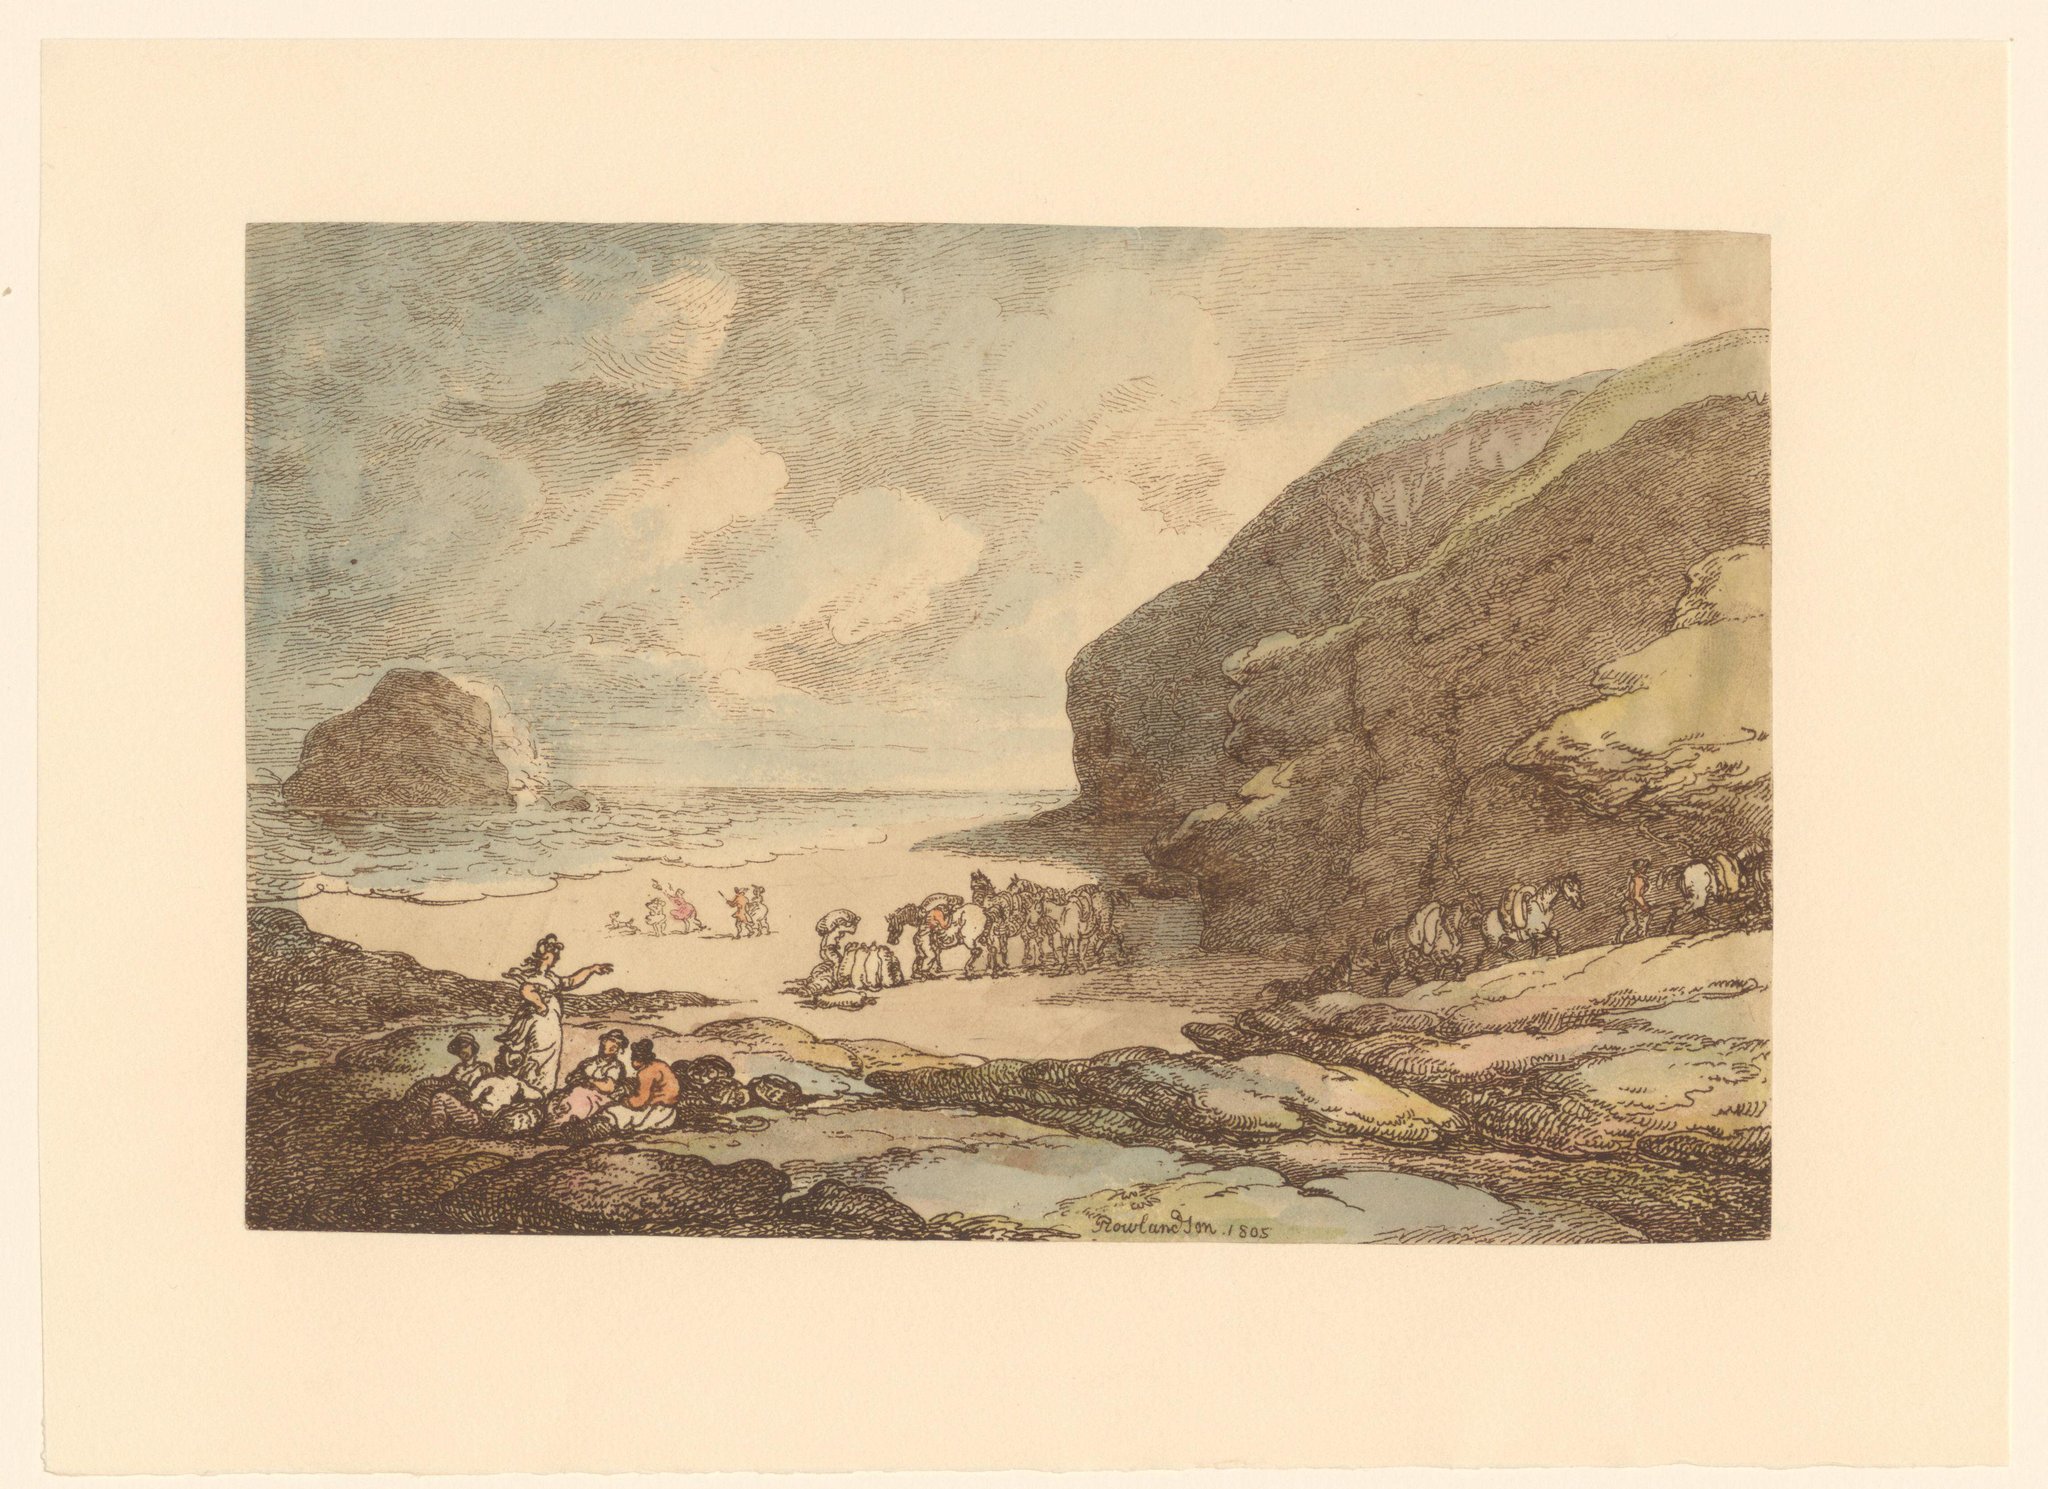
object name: print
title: Inham aan het strand omgeven door rotsen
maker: thomas rowlandson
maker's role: draughtsman, print maker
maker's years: 1756-1827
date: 1805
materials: paper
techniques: etching, hand coloring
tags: fjord, sea loch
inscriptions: collector's mark: Lugt 2228